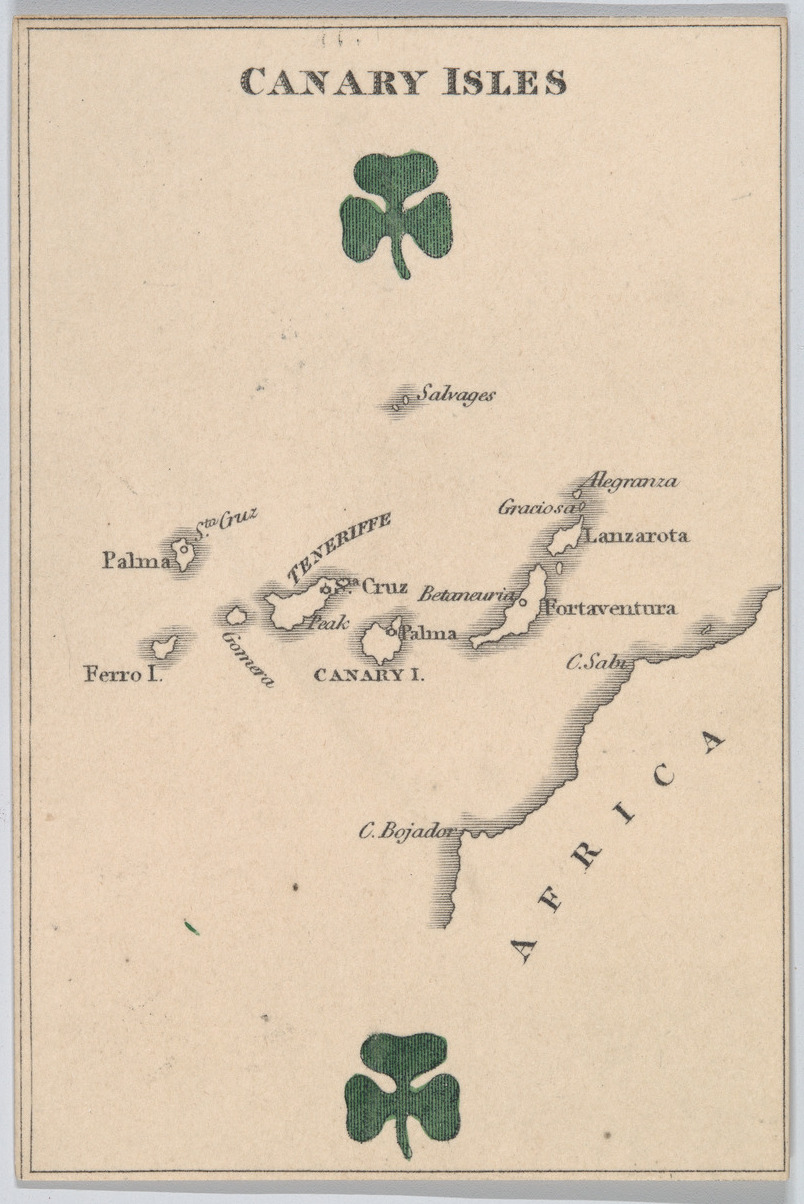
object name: print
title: Canary Isles, from "Court Game of Geography"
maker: william and henry rock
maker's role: publisher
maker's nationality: british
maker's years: 1821-1884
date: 1838-1855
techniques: engraving, hand coloring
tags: playing cards,maps